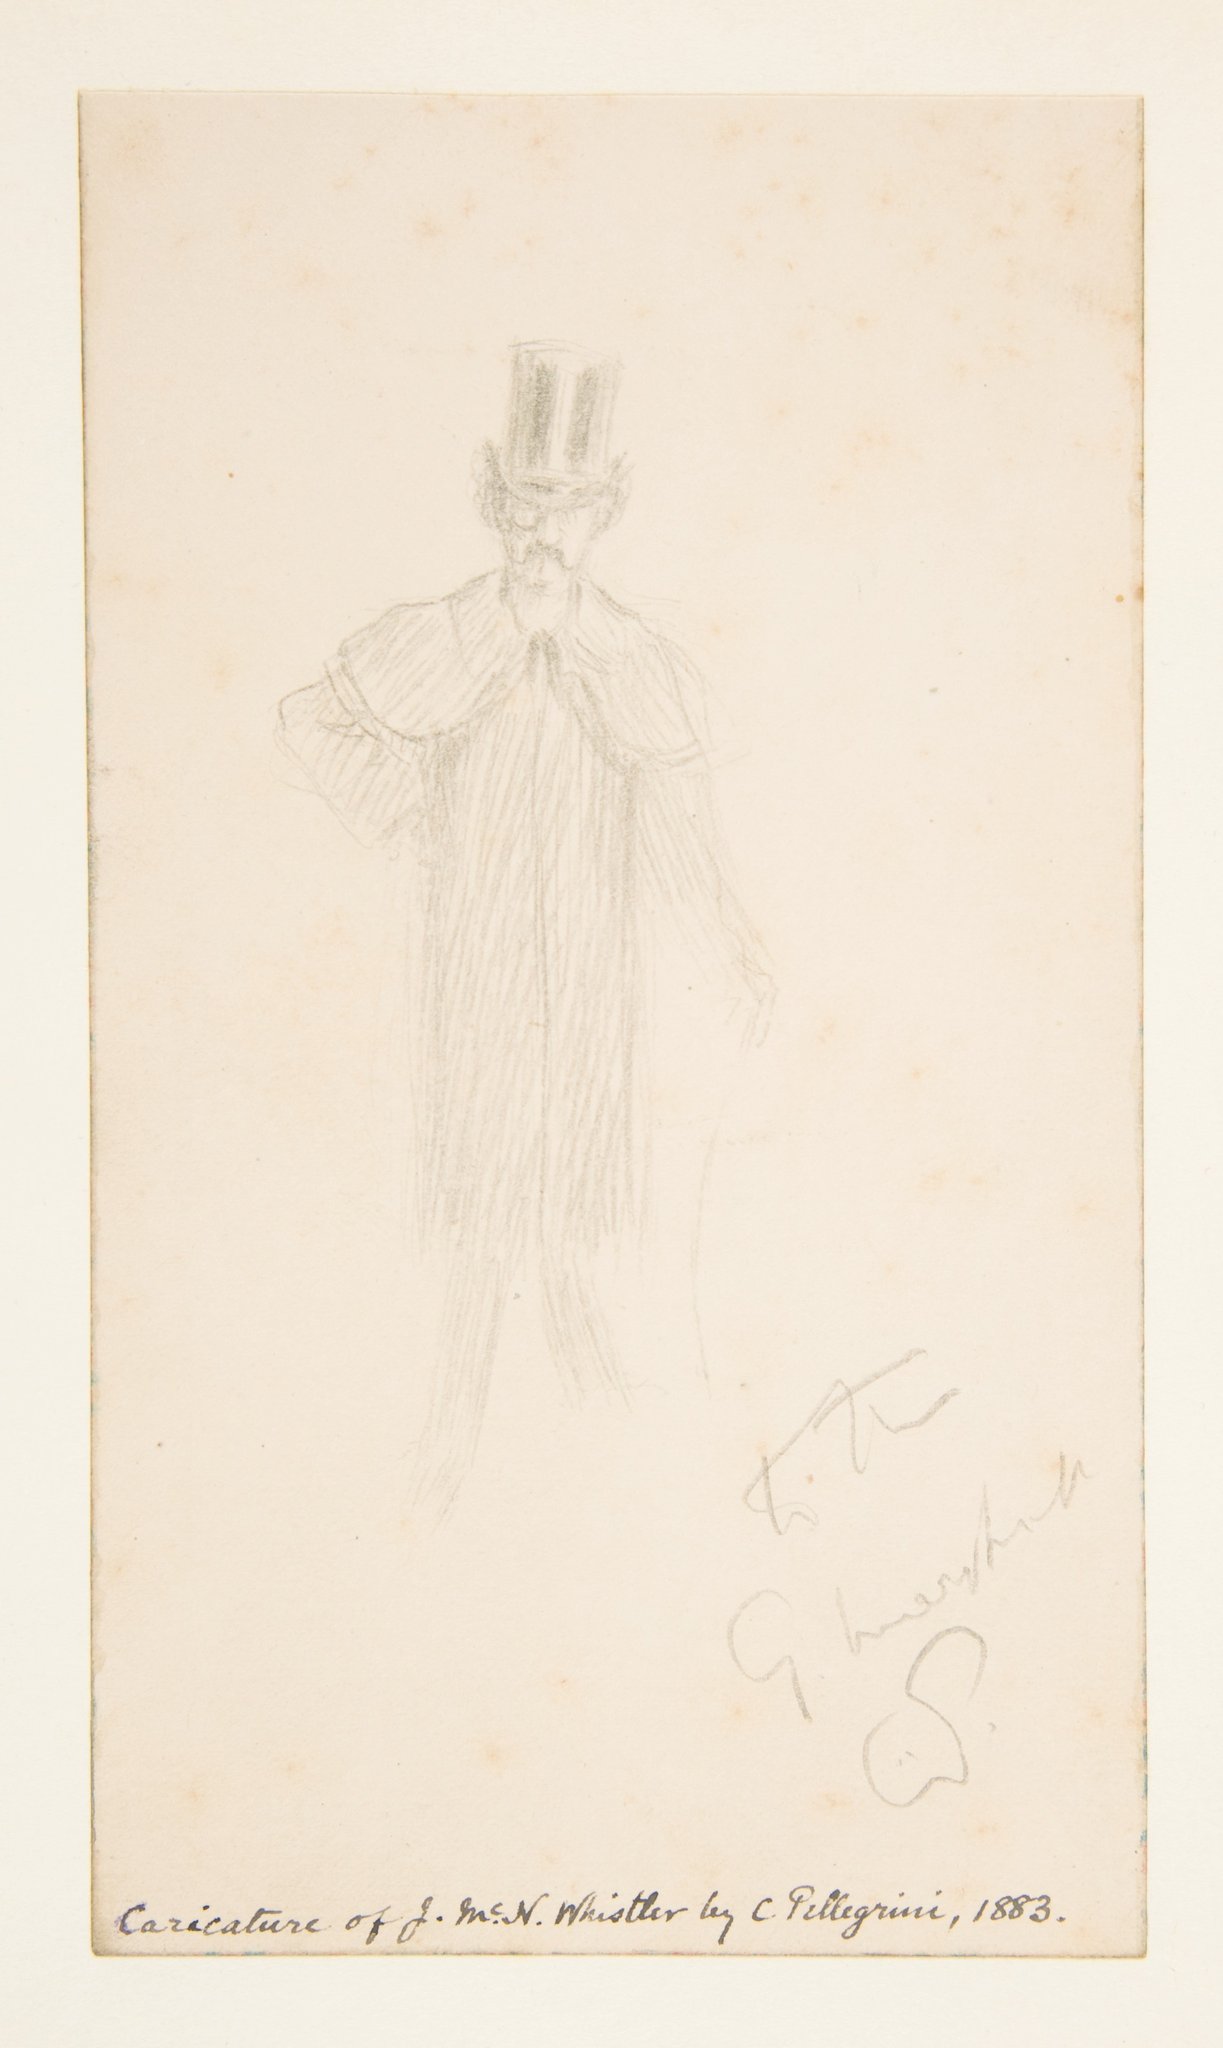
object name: drawing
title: Caricature of James McNeil Whistler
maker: carlo pellegrini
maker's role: artist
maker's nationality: italian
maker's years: 1839-1889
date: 1883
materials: graphite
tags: men